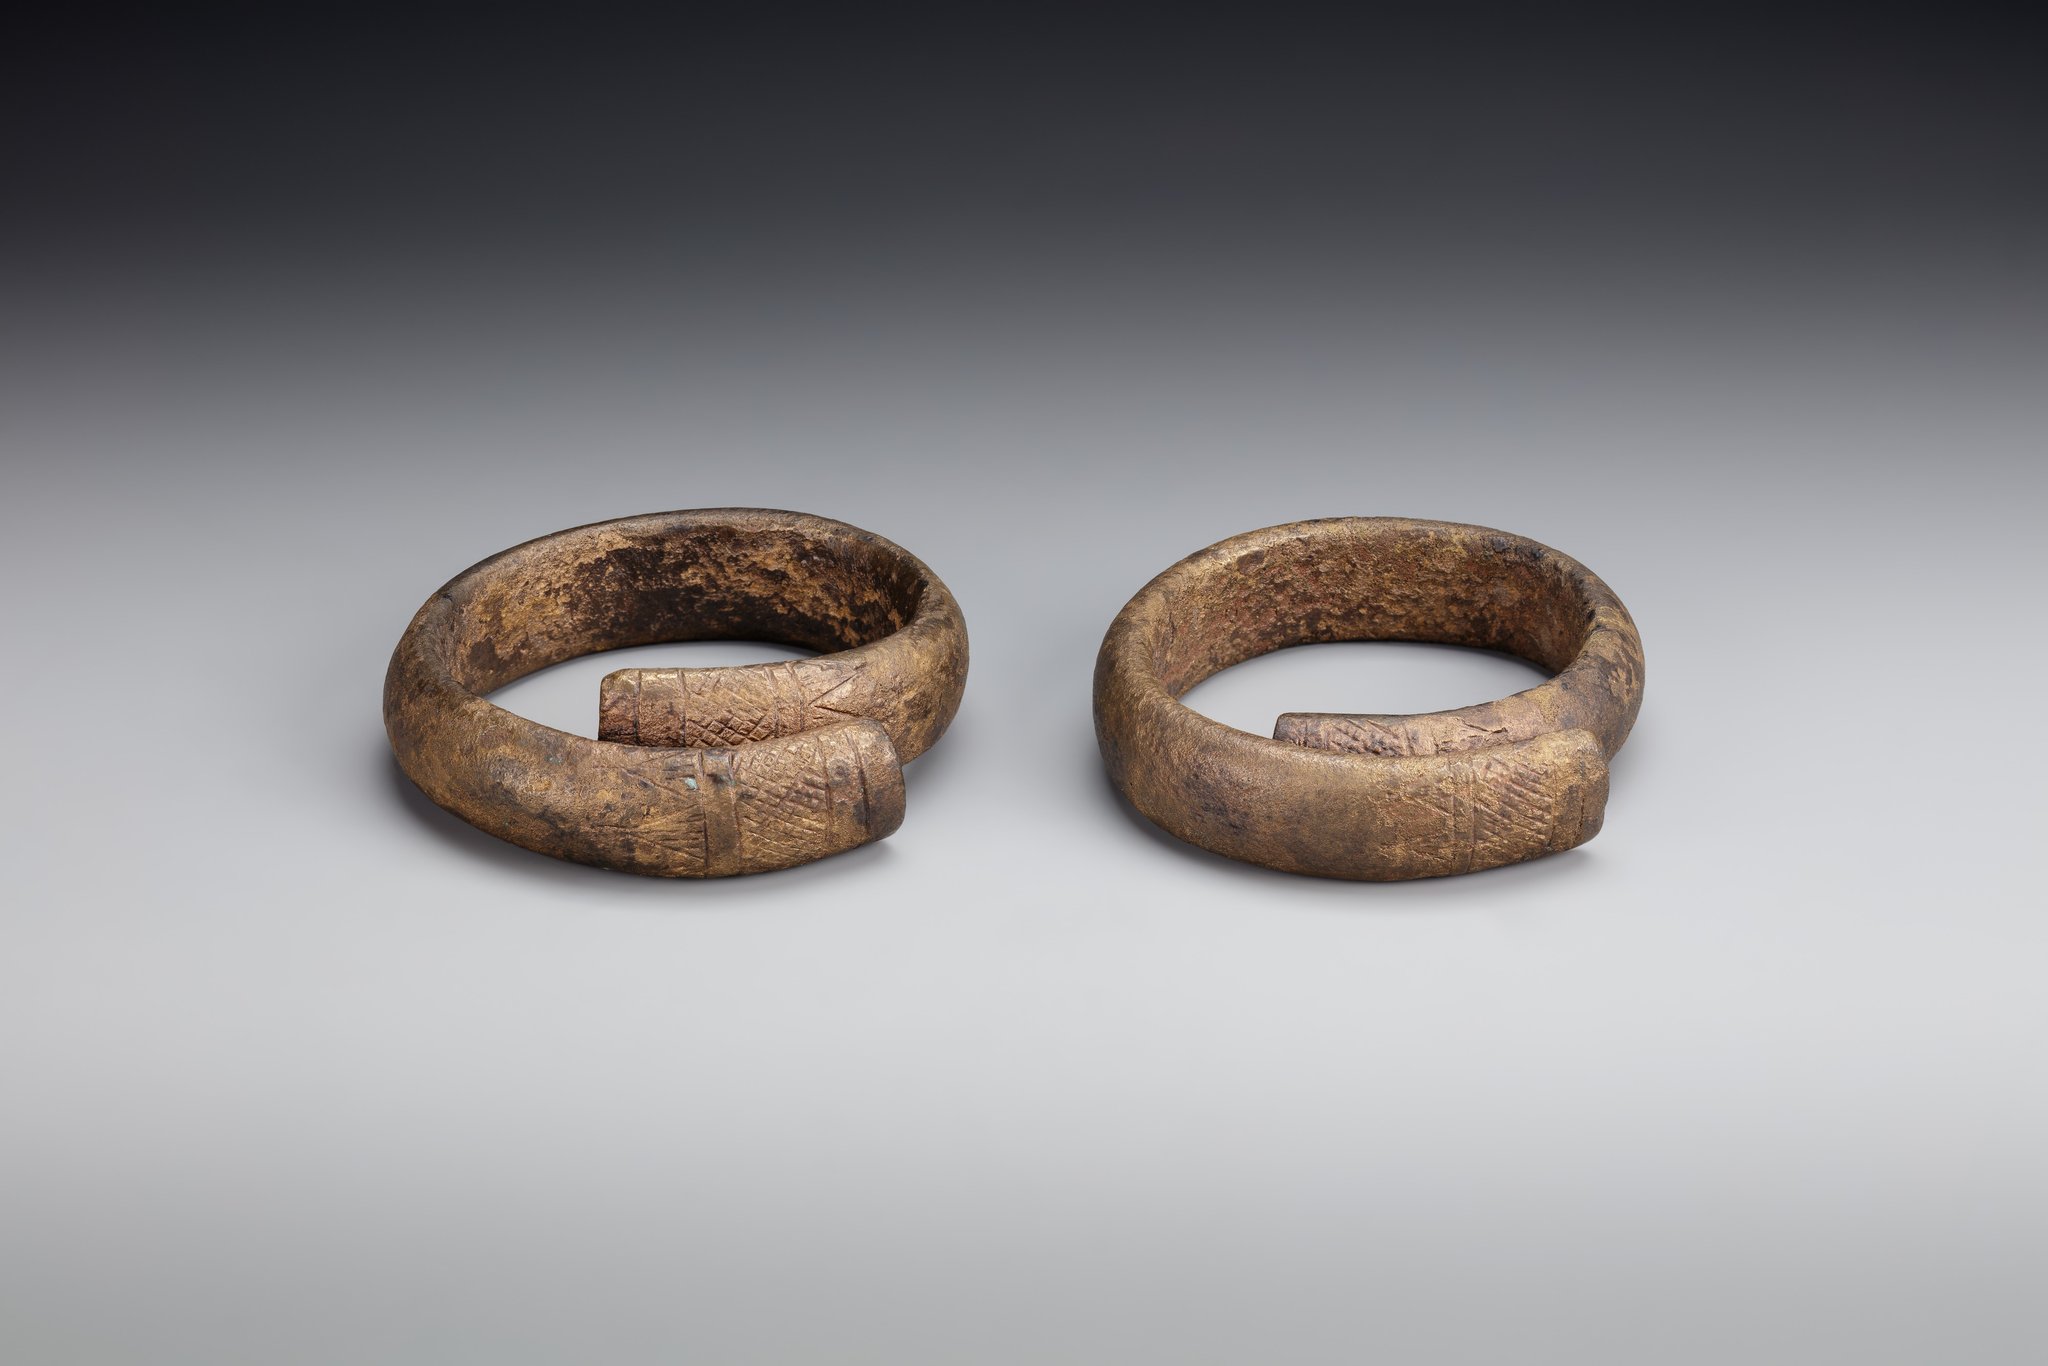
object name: anklet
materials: copper alloy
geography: nubia